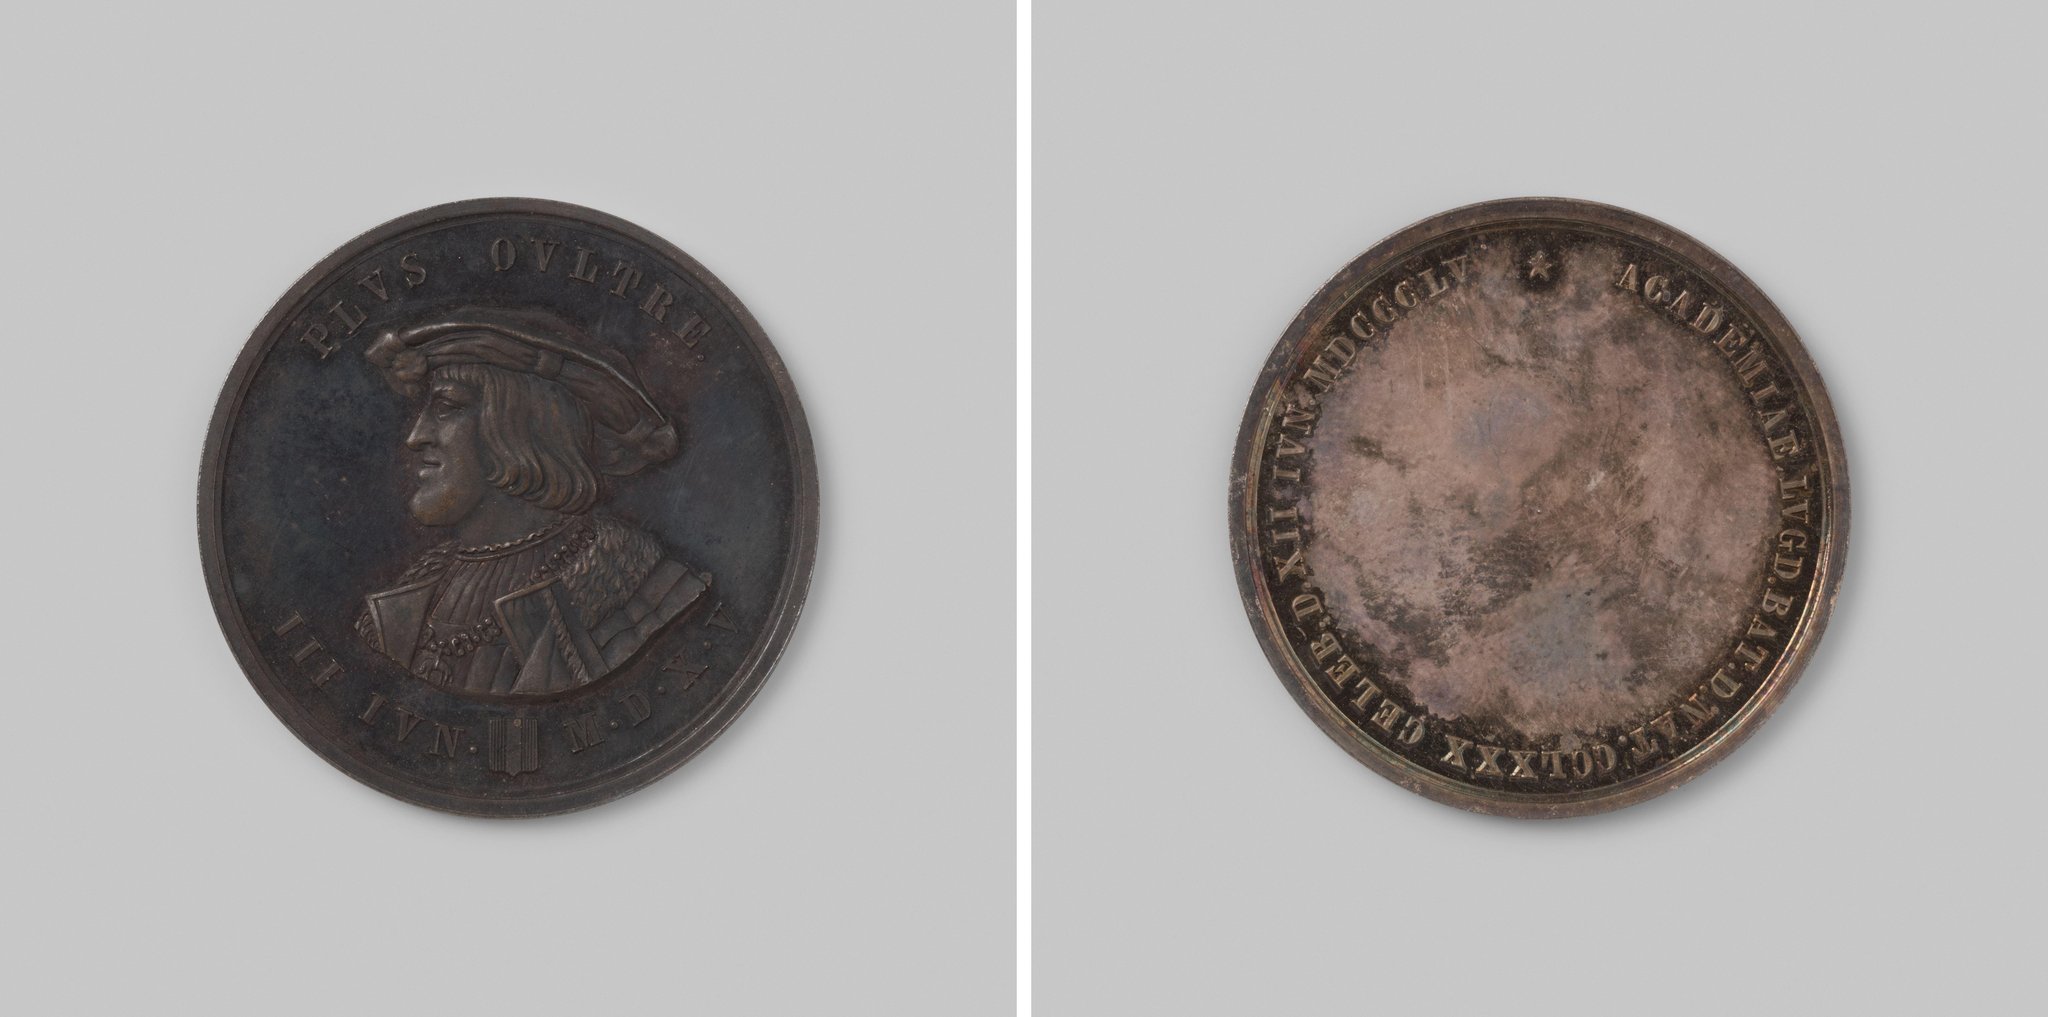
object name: history medal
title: Gemaskerde optocht door de studenten, voorstellende de intocht van Karel V, Duits keizer in Dordrecht, ter ere van de 280e stichtingsdag van de Universiteit van Leiden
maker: Anonymous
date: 1855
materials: silver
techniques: striking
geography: utrecht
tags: charles v (holy roman emperor and king of spain), leiden, dordrecht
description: Zilveren penning. Voorzijde: borststuk man binnen omschrift. Keerzijde: blanco veld onder ster binnen omschrift